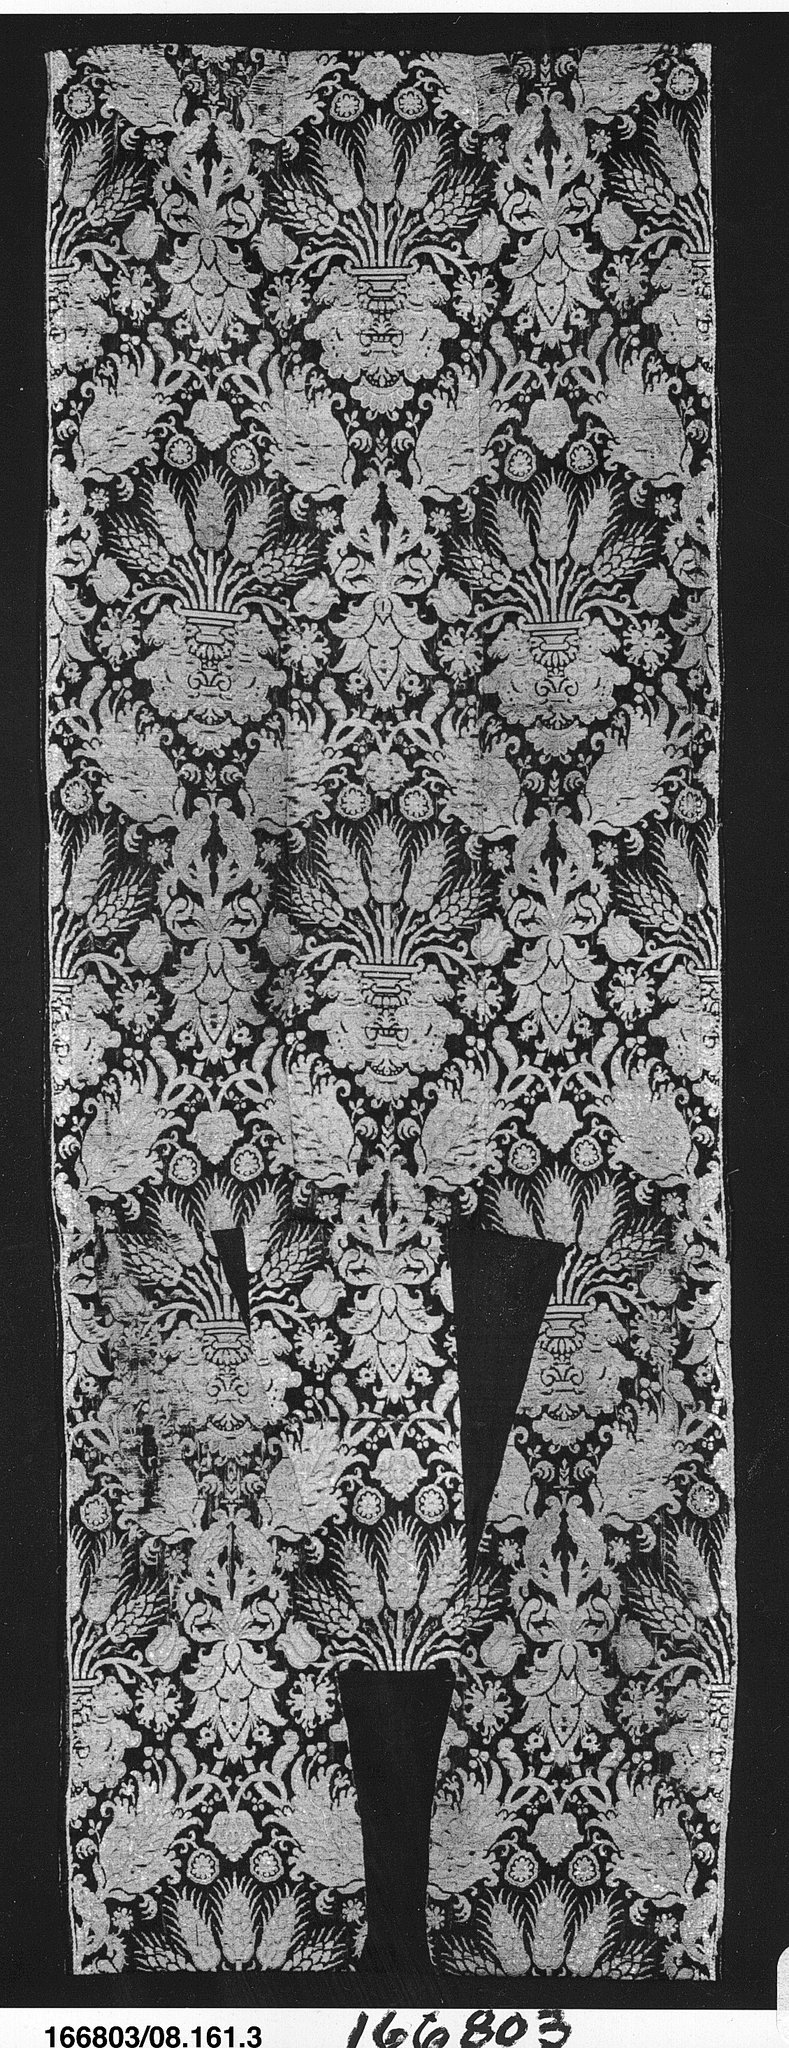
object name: piece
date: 1720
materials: linen, metal thread, silk